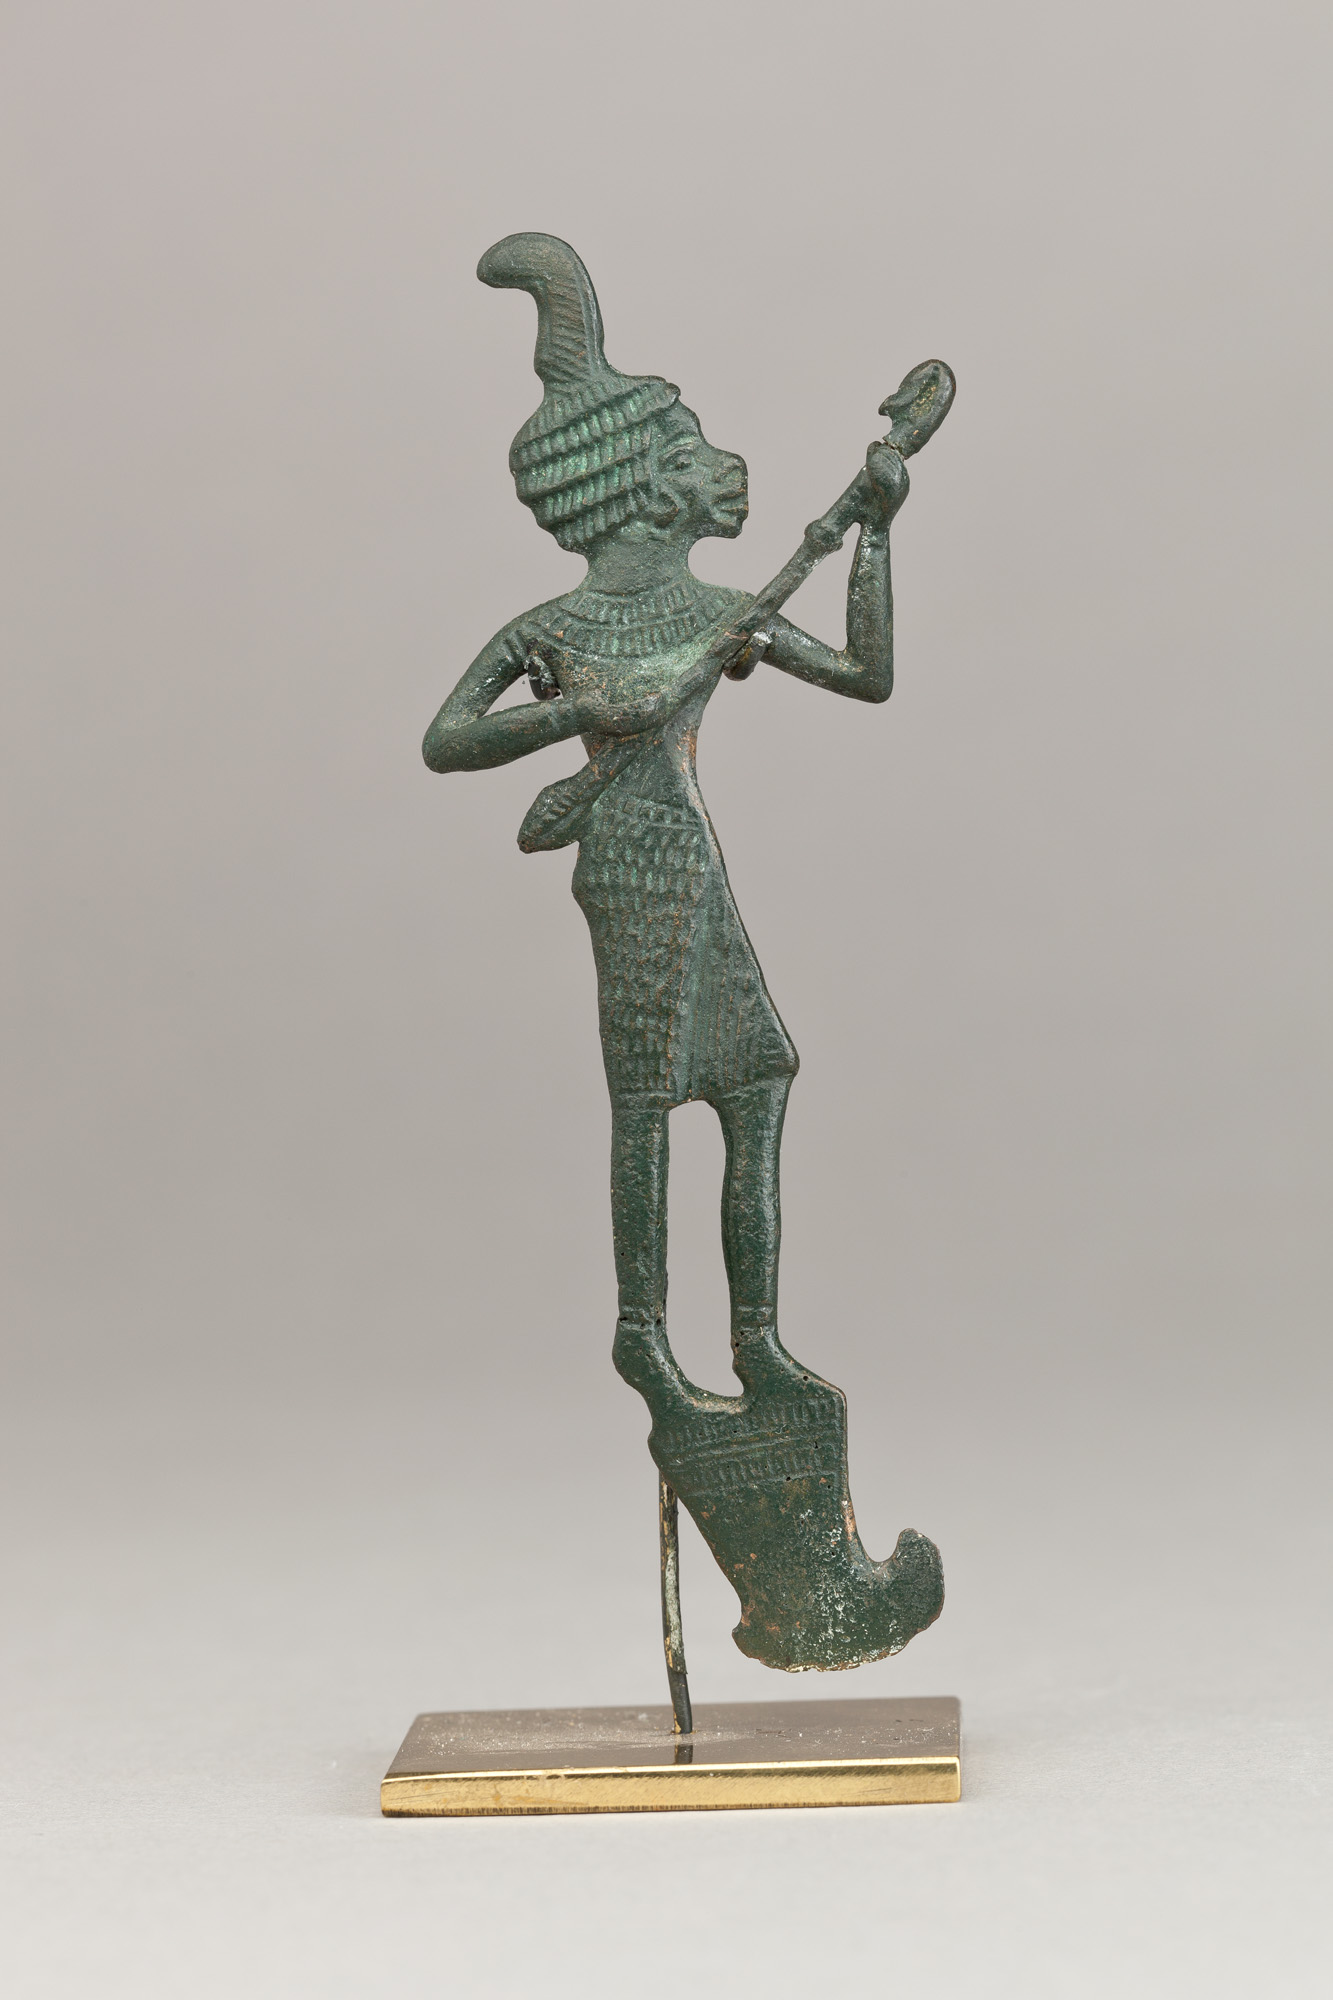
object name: razor, nubian with lute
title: Razor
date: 1390-1295 BCE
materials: bronze, copper alloy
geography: egypt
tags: musicians